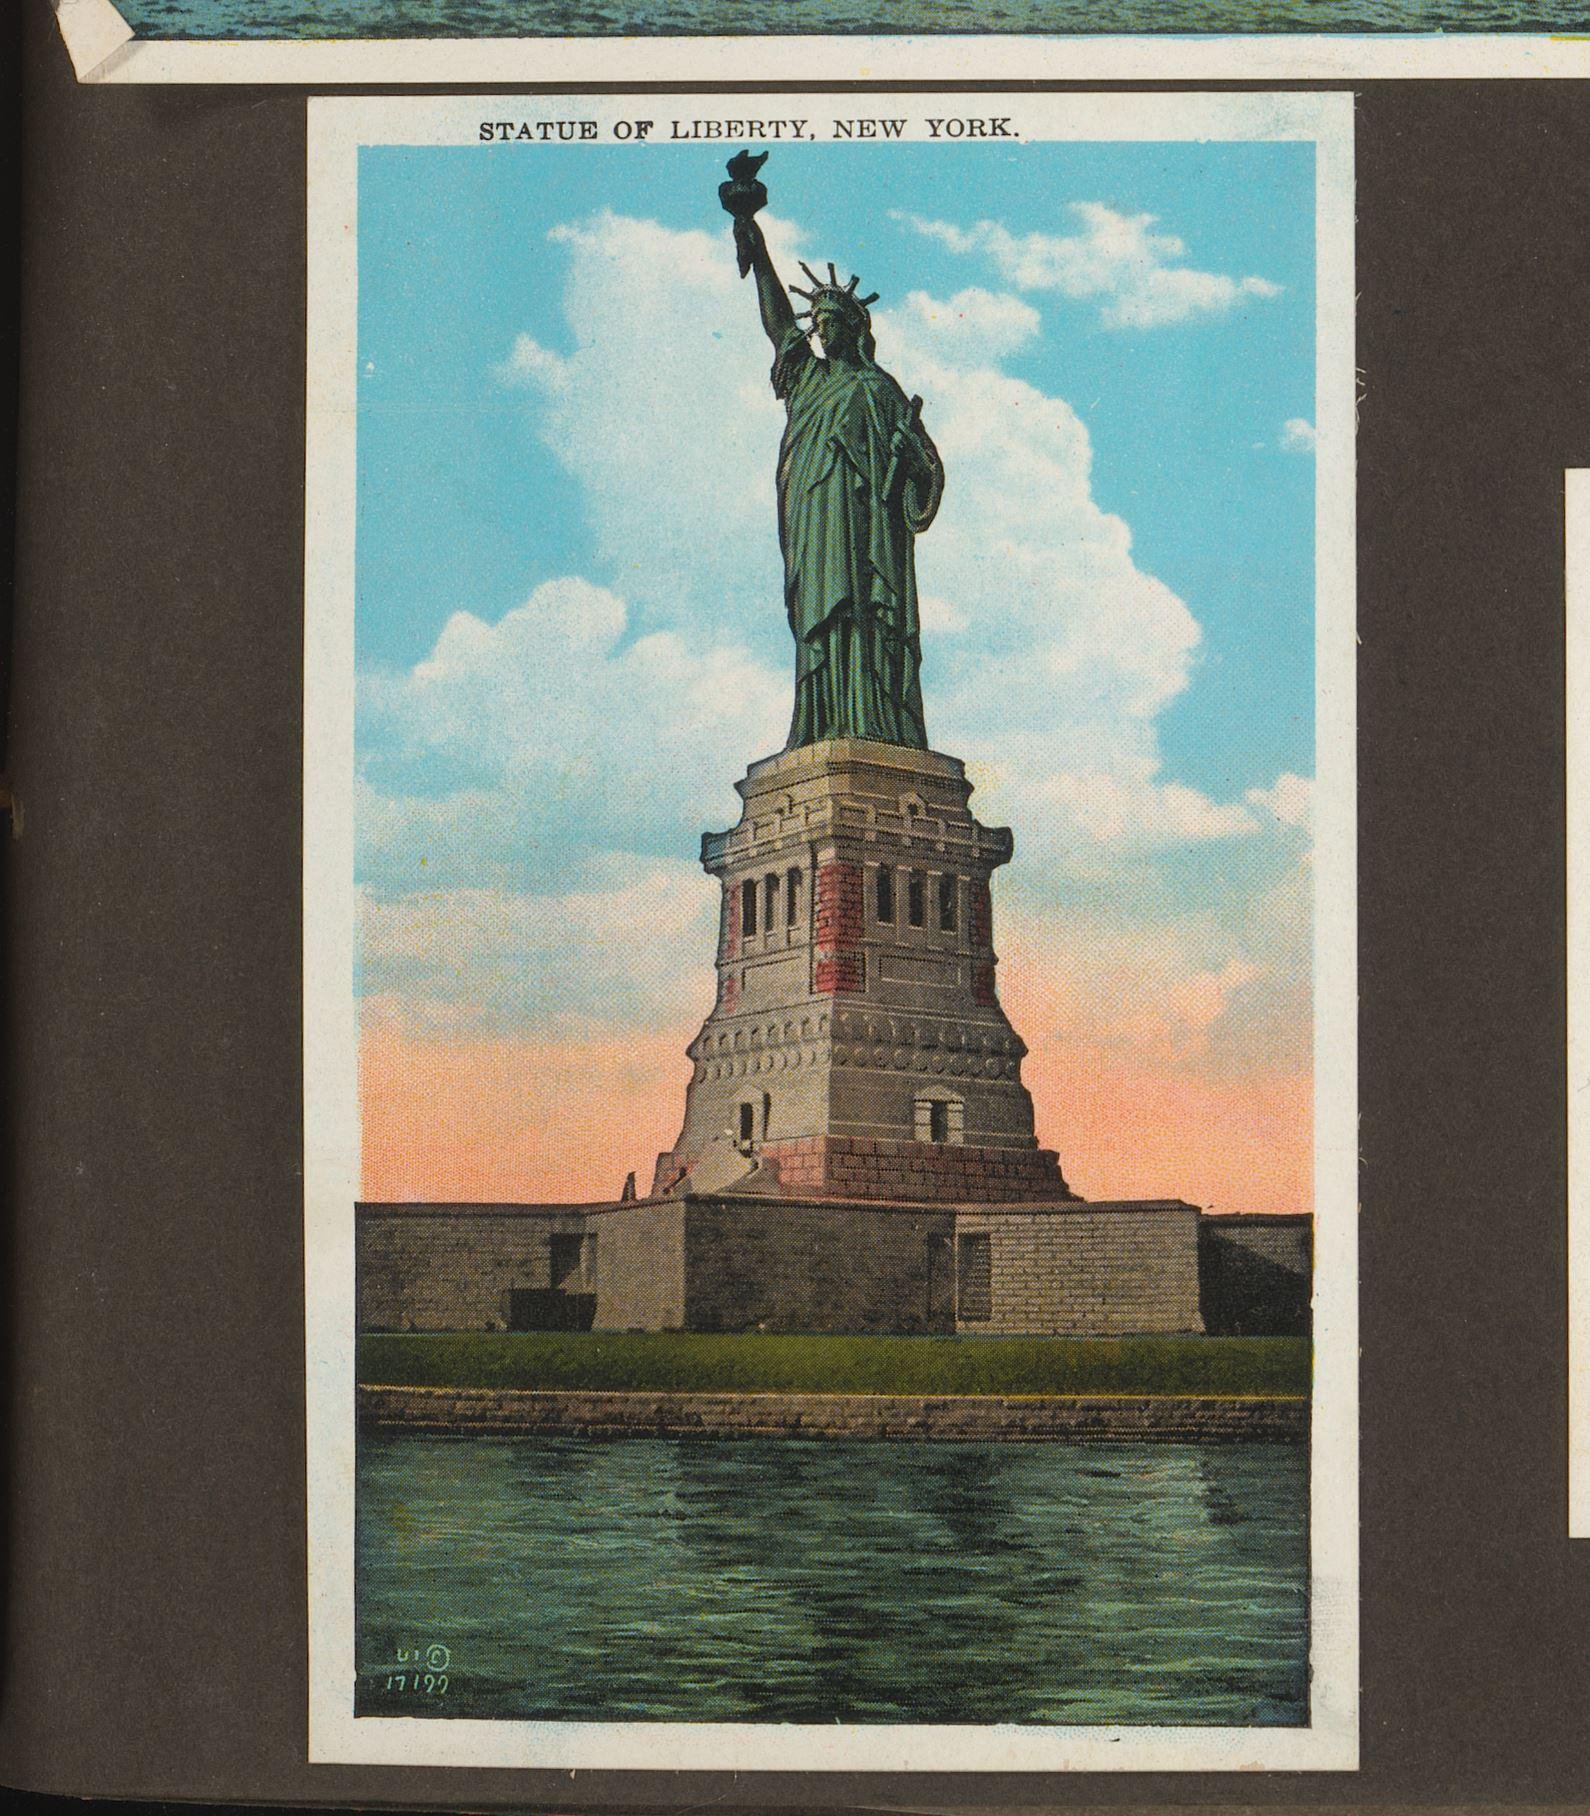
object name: album leaf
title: Statue of liberty, New York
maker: irving s. underhill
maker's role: fotograaf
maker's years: 1872-1960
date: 1928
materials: paper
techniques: four-color autotype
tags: river, monument, statue, statue of liberty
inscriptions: number: ‘17199 © U.I.’